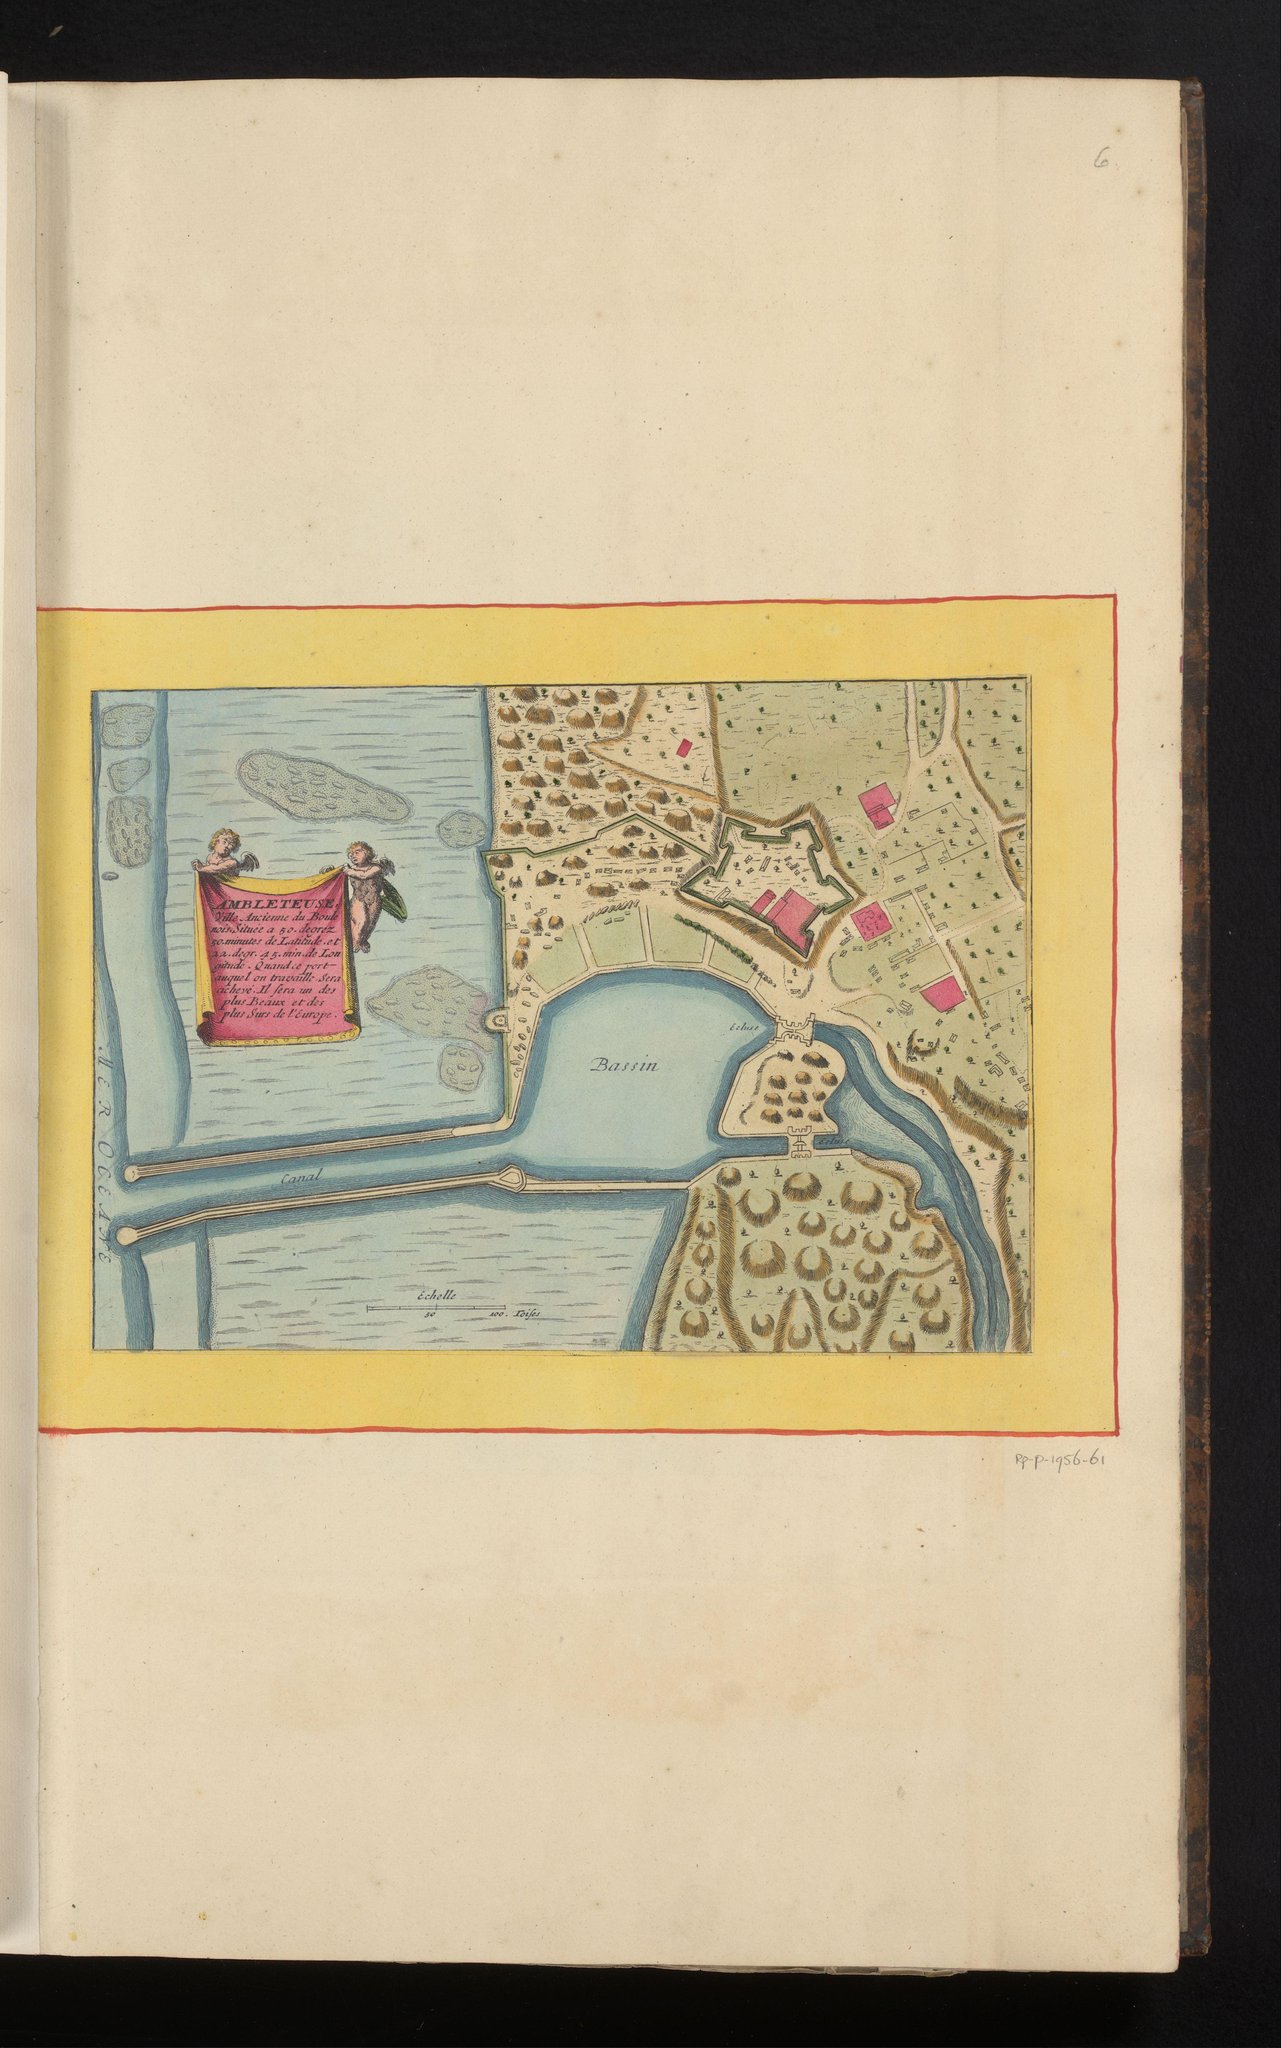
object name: map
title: Ambleteuse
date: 1690-1702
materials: paper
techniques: engraving, etching, hand coloring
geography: the hague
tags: maps of cities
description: Kaart gebruikt in: Fer, Nicolas de. Les forces de l'Europe. 8 dln. Parijs: Nicolas de Fer, 1690-1695. Mortier, Pieter. Les forces de l'Europe. 10 dln. Amsterdam: Pieter Mortier, ca. 1700. Mortier, Pieter. Les forces de l'Europe. 12 dln. Amsterdam: Pieter Mortier, 1702.